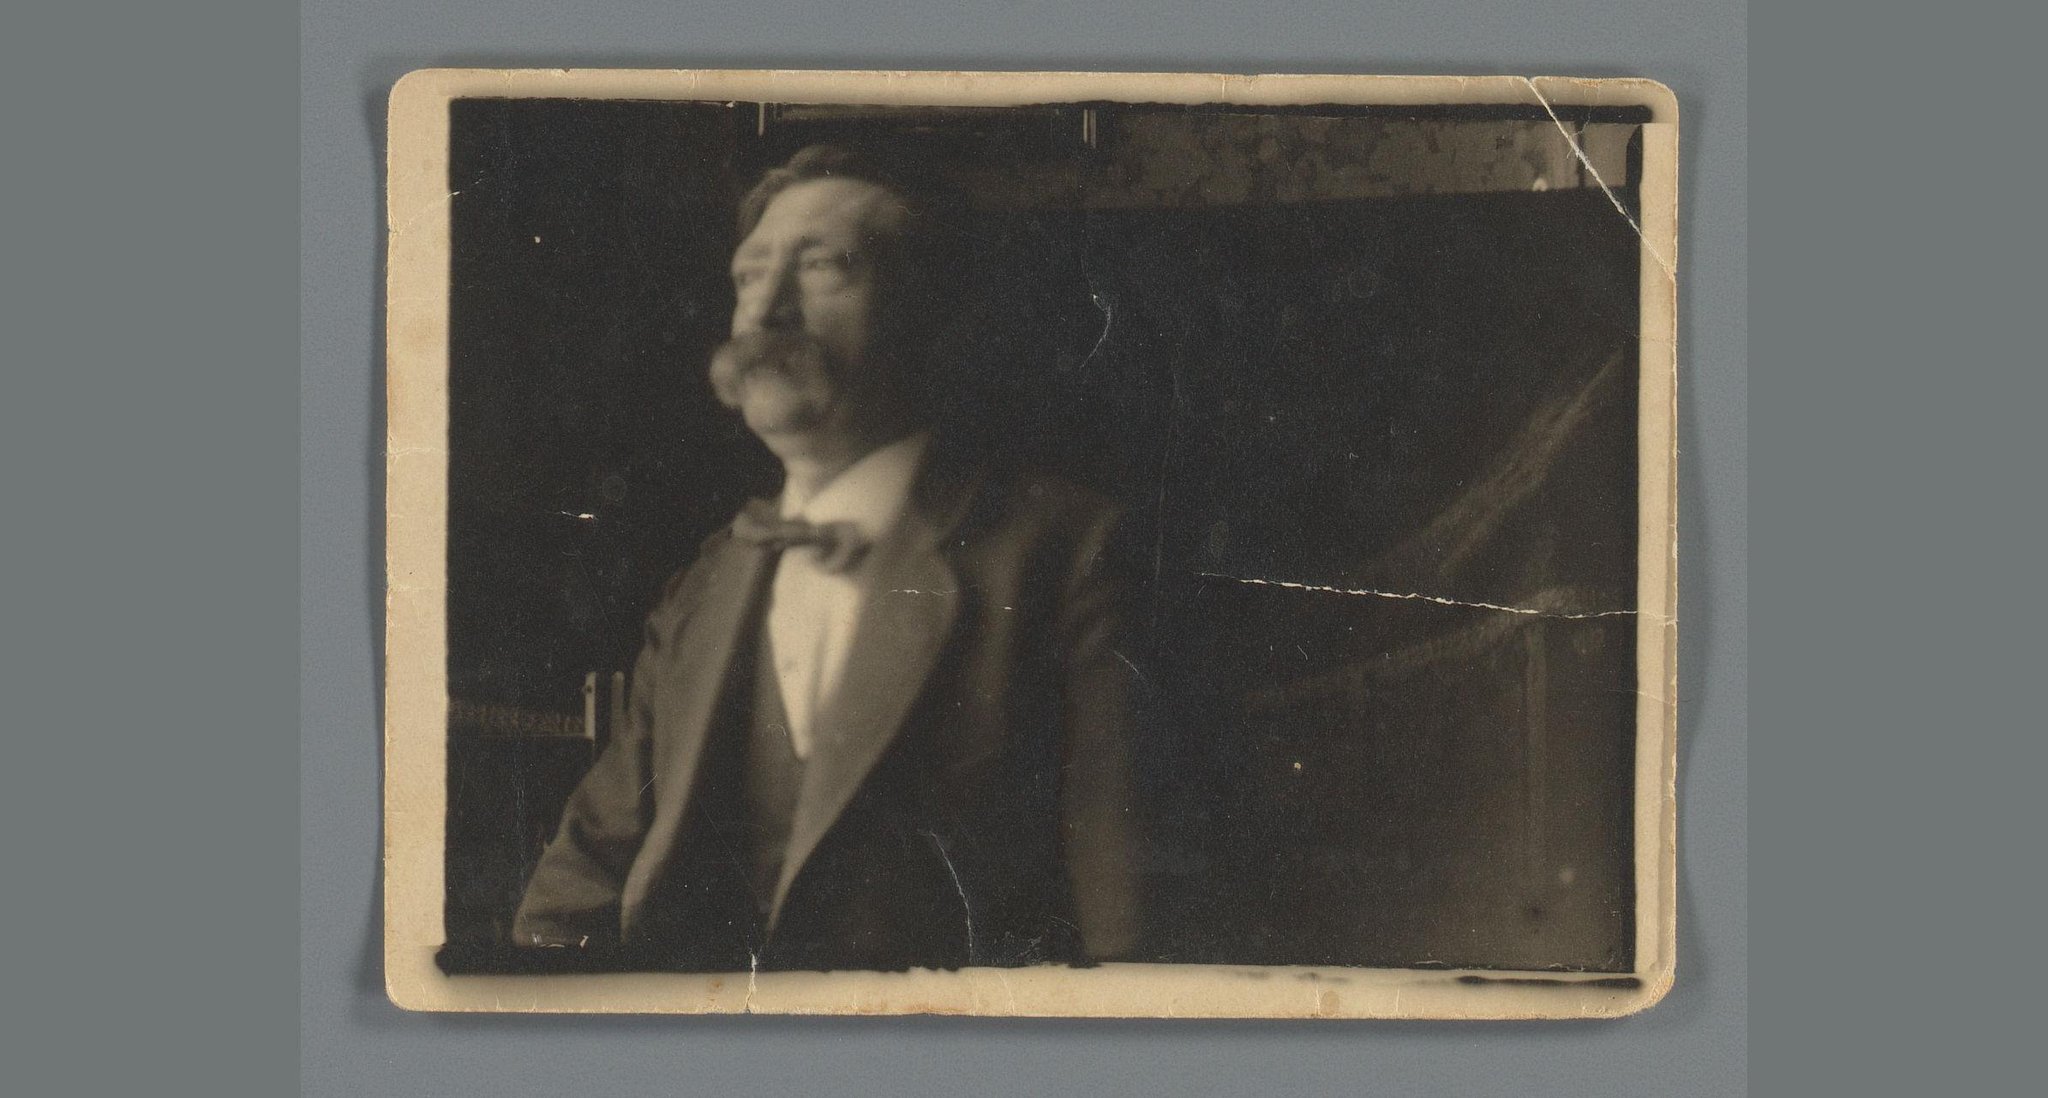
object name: photograph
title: Portret van een onbekende man met snor, aangeduid als opa Noordhoff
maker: Anonymous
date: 1920-1930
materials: paper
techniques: gelatin silver print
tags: historical persons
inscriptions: inscription: ‘opa/ Noordhoff’